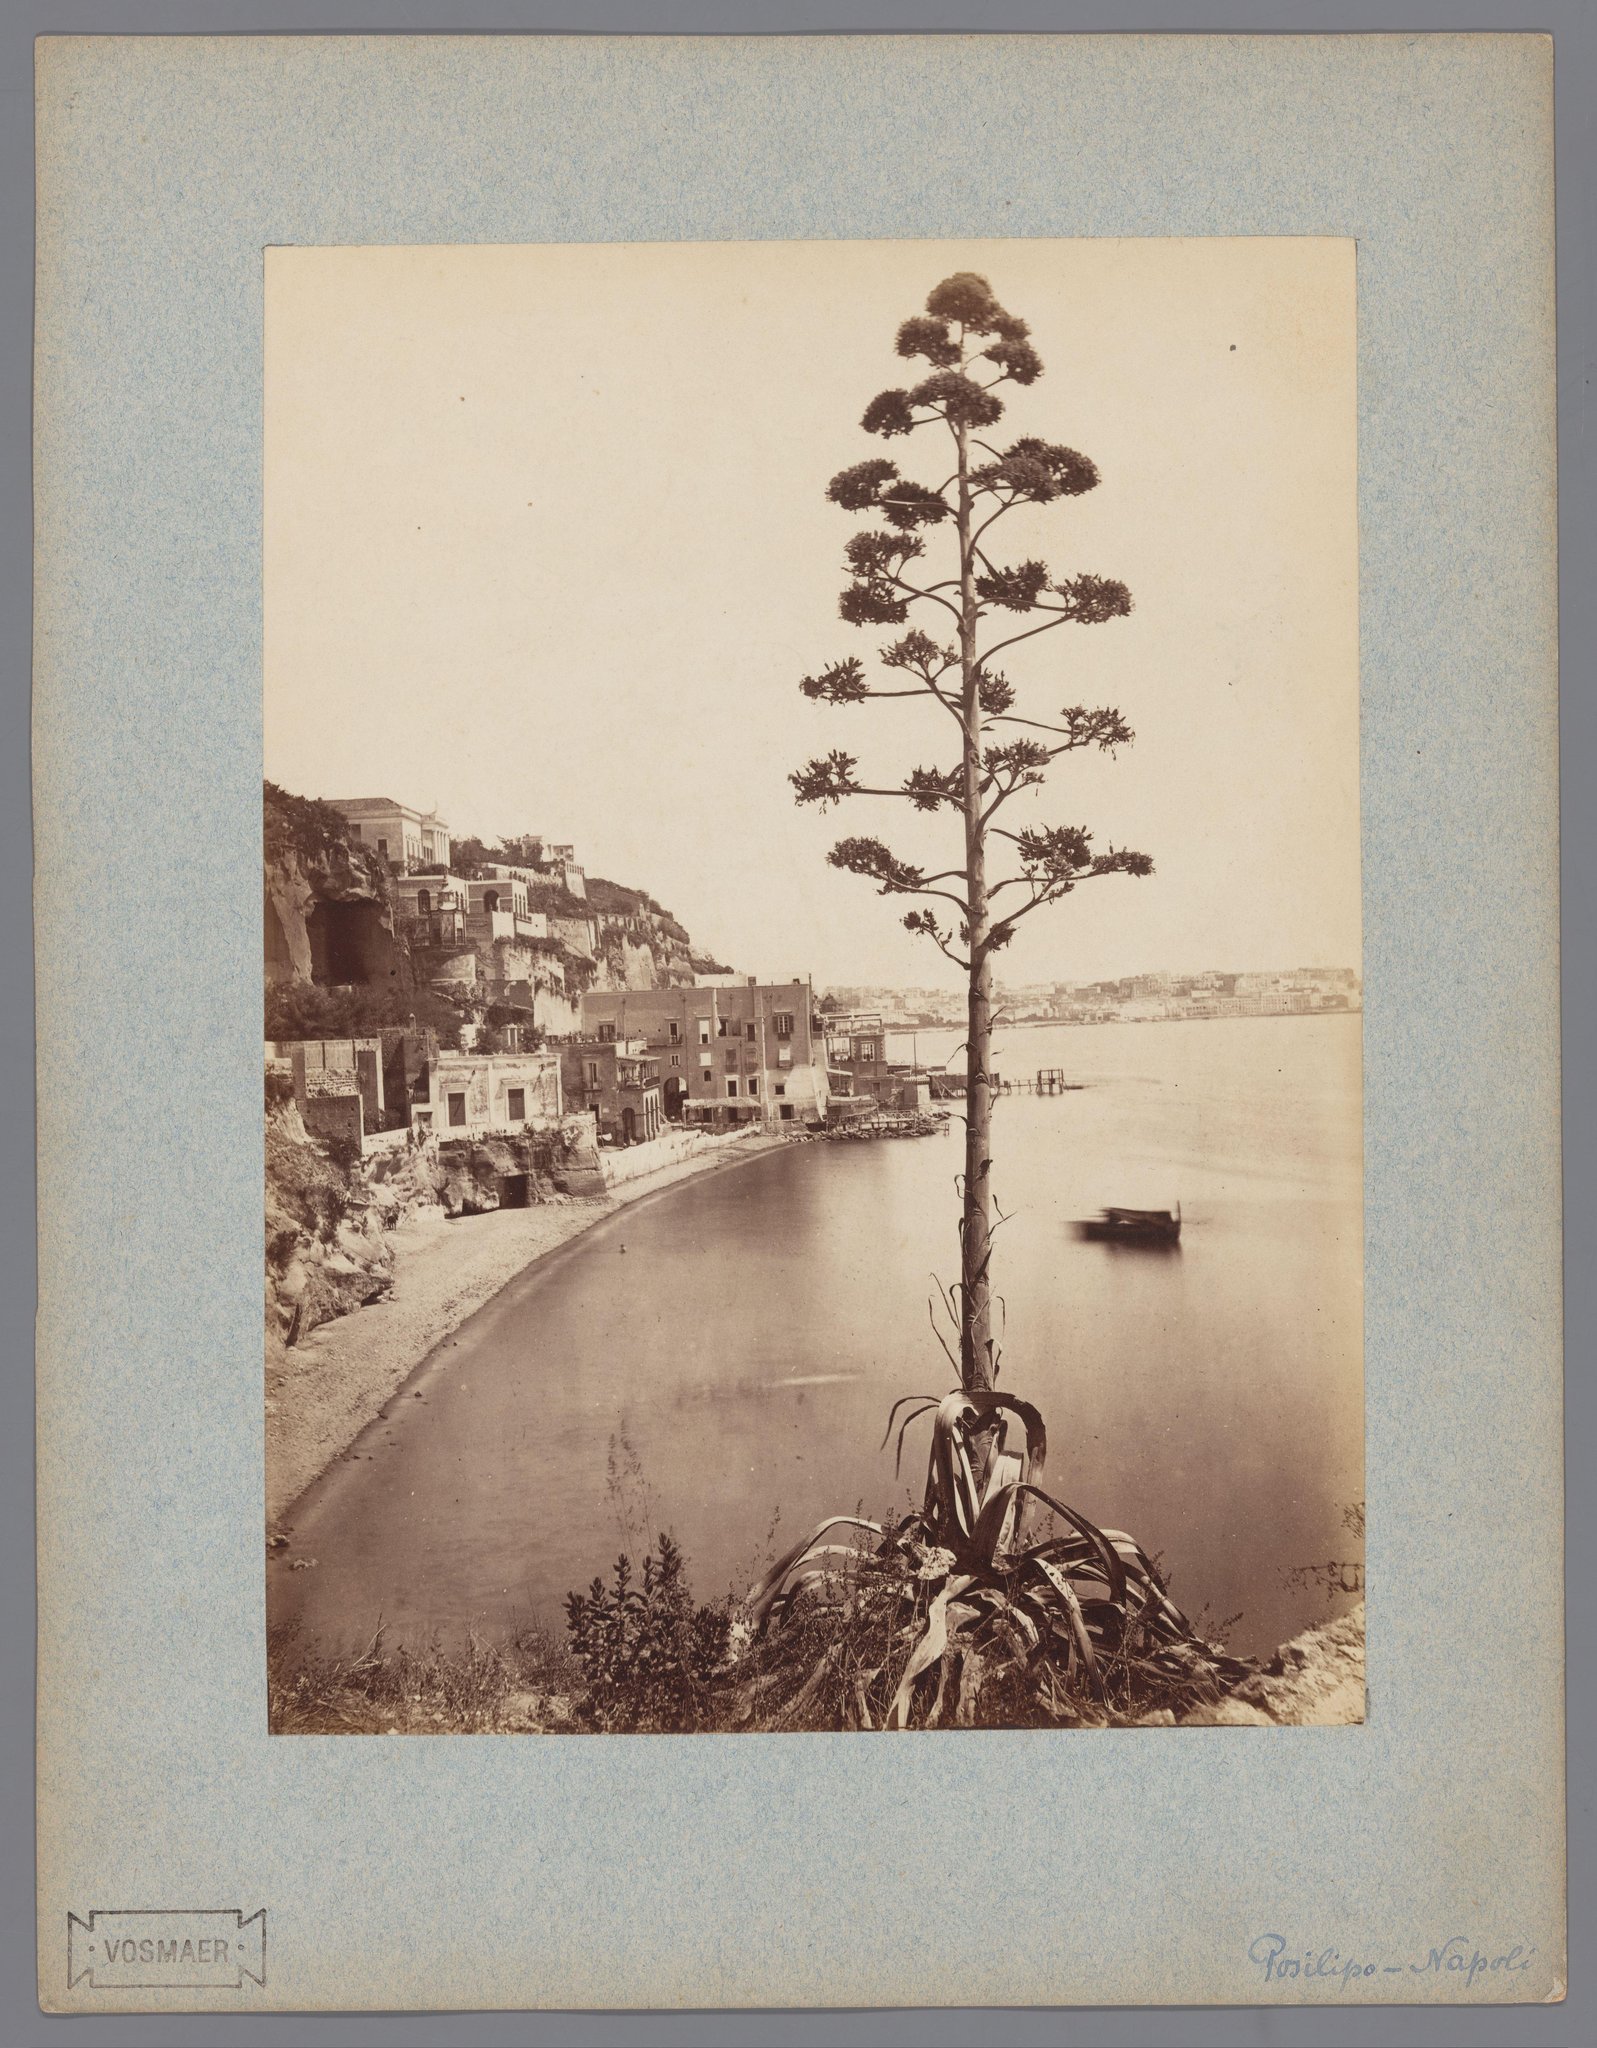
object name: photograph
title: Posilippo, Napoli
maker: Anonymous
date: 1851-1900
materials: cardboard, paper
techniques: albumen print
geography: posillipo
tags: trees, landscapes in the temperate zone, coast, posillipo, collina di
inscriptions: number: ‘6128’, collector's mark: ‘VOSMAER’